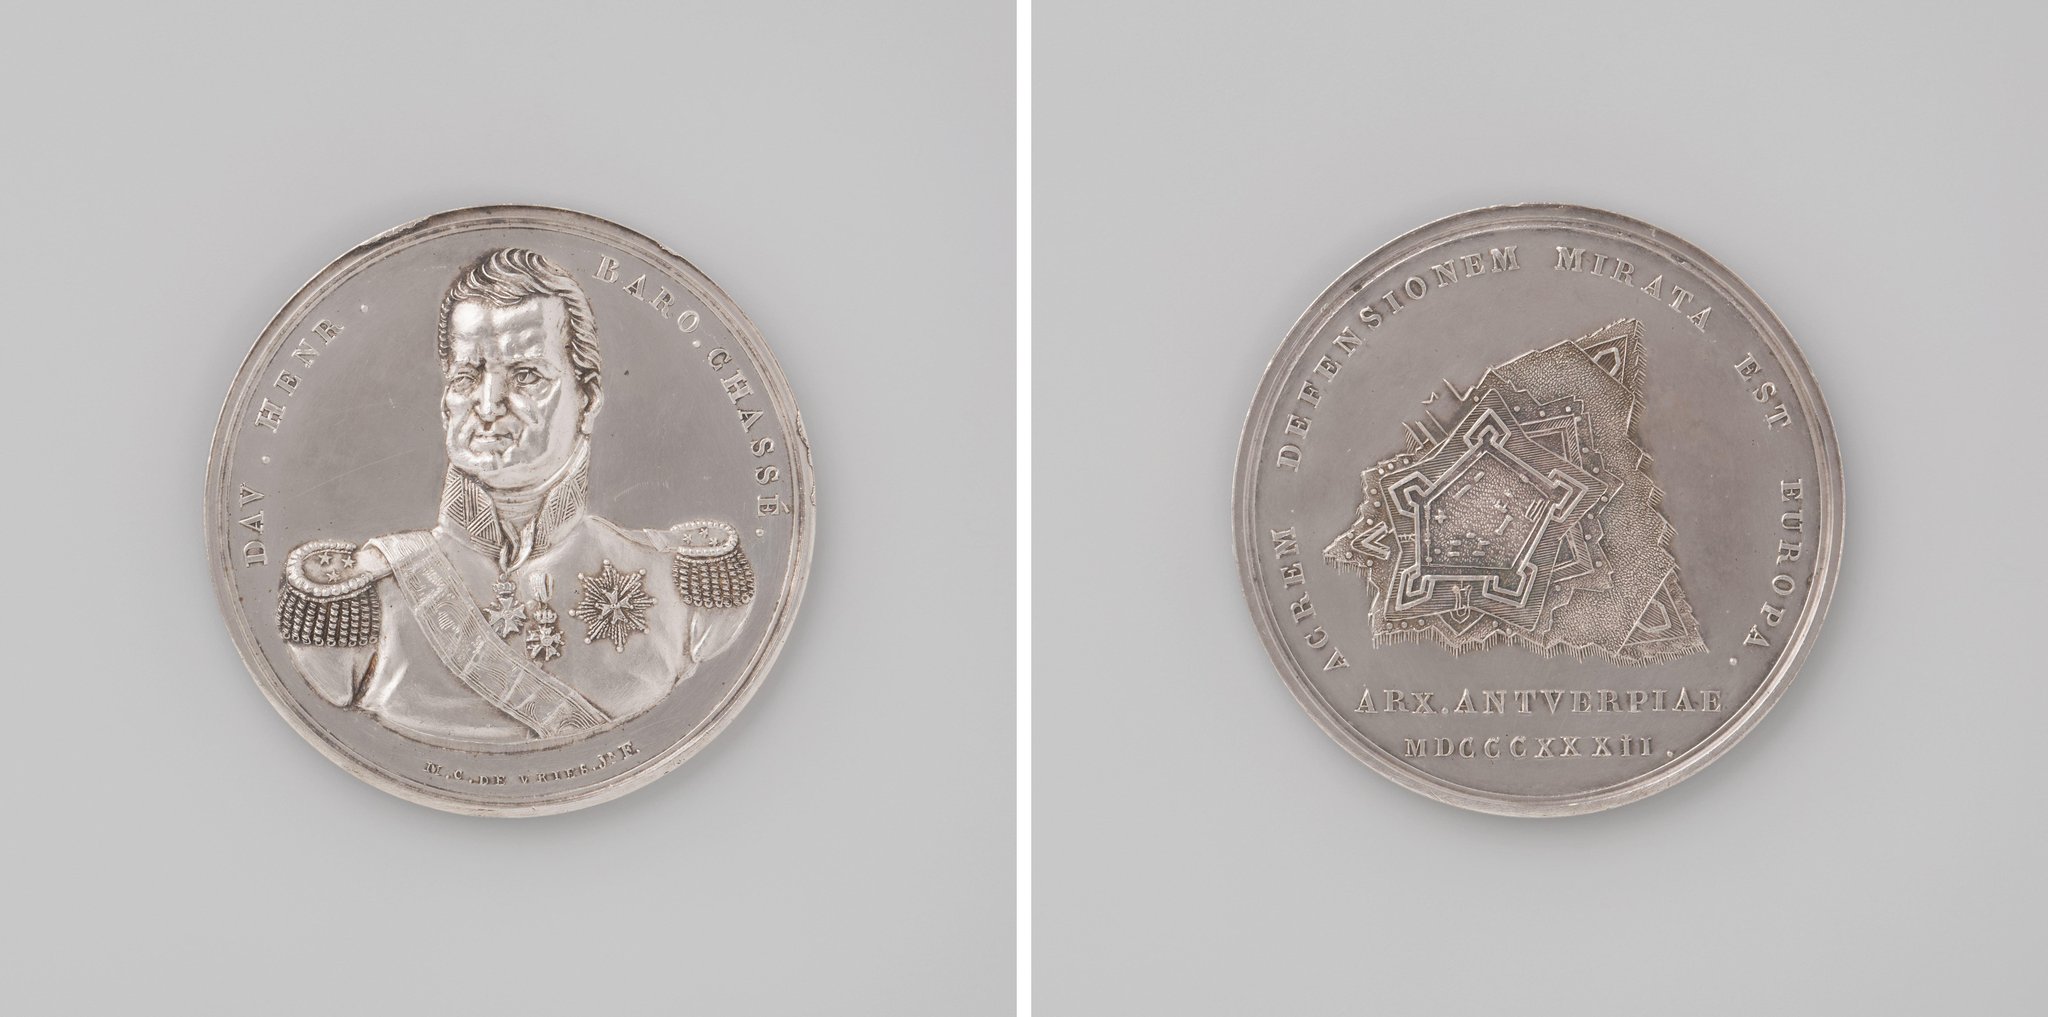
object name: history medal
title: Verdediging van de citadel van Antwerpen, ter ere van Chassé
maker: moses cohen de vries junior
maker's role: diamantslijper, graveur, medailleur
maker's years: 1807-1883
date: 1832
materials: silver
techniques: striking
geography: amsterdam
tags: david hendrik baron chassé, antwerp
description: Zilveren penning. Voorzijde: borststuk man binnen omschrift. Keerzijde: plattegrond van citadel van Antwerpen binnen omschrift boven opschrift